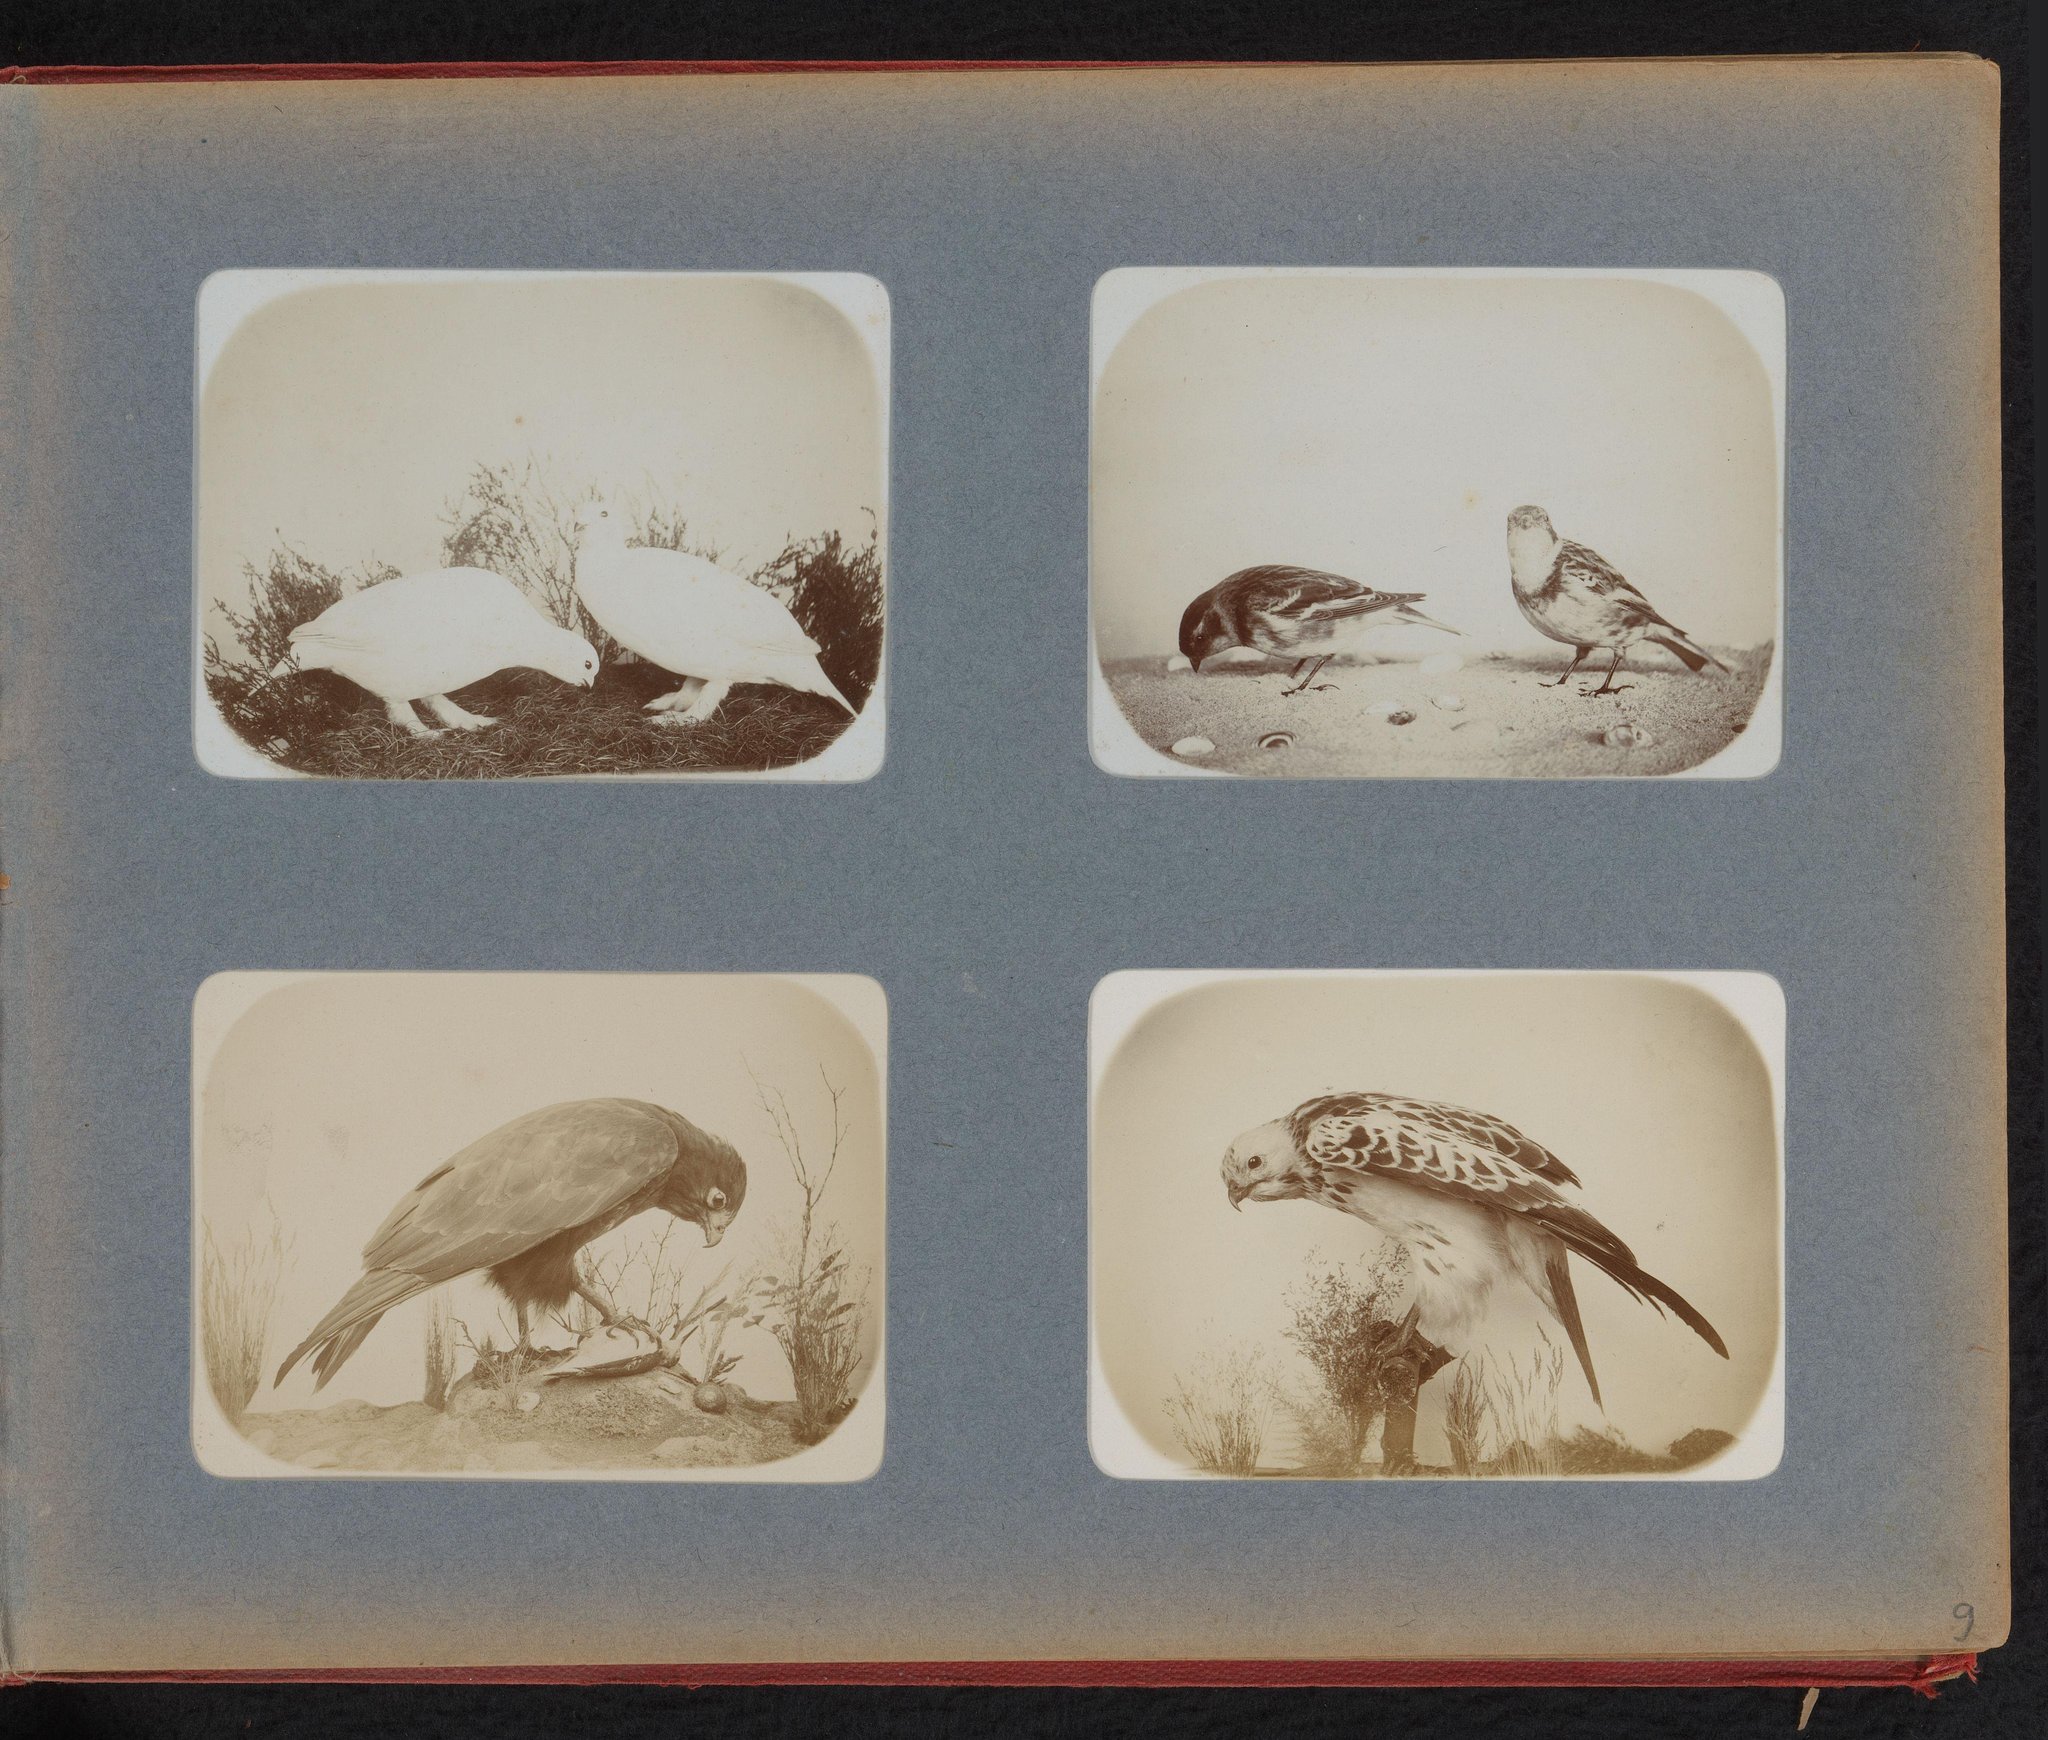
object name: photograph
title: Opgezette witte vogels, bonte vliegenvangers, kraai en buizerd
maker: Anonymous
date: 1895-1910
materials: paper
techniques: gelatin silver print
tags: other birds, song-birds: crow, predatory birds: buzzard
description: Deze foto's maken deel uit van een album.